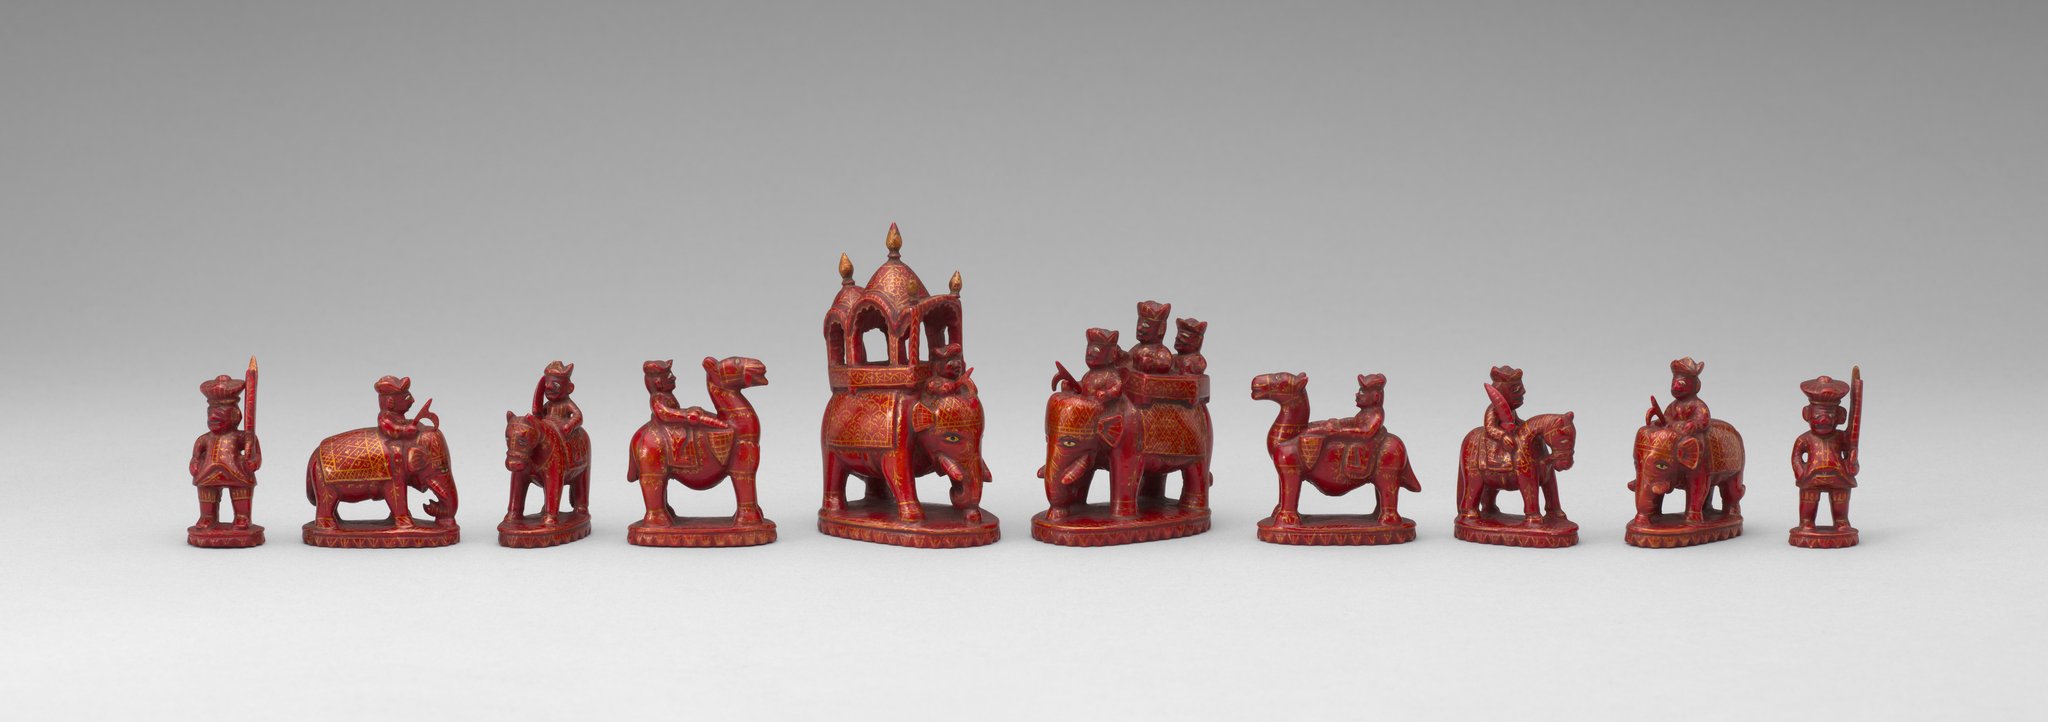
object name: chessman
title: Chessmen (32)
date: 1767-1800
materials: ivory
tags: chess